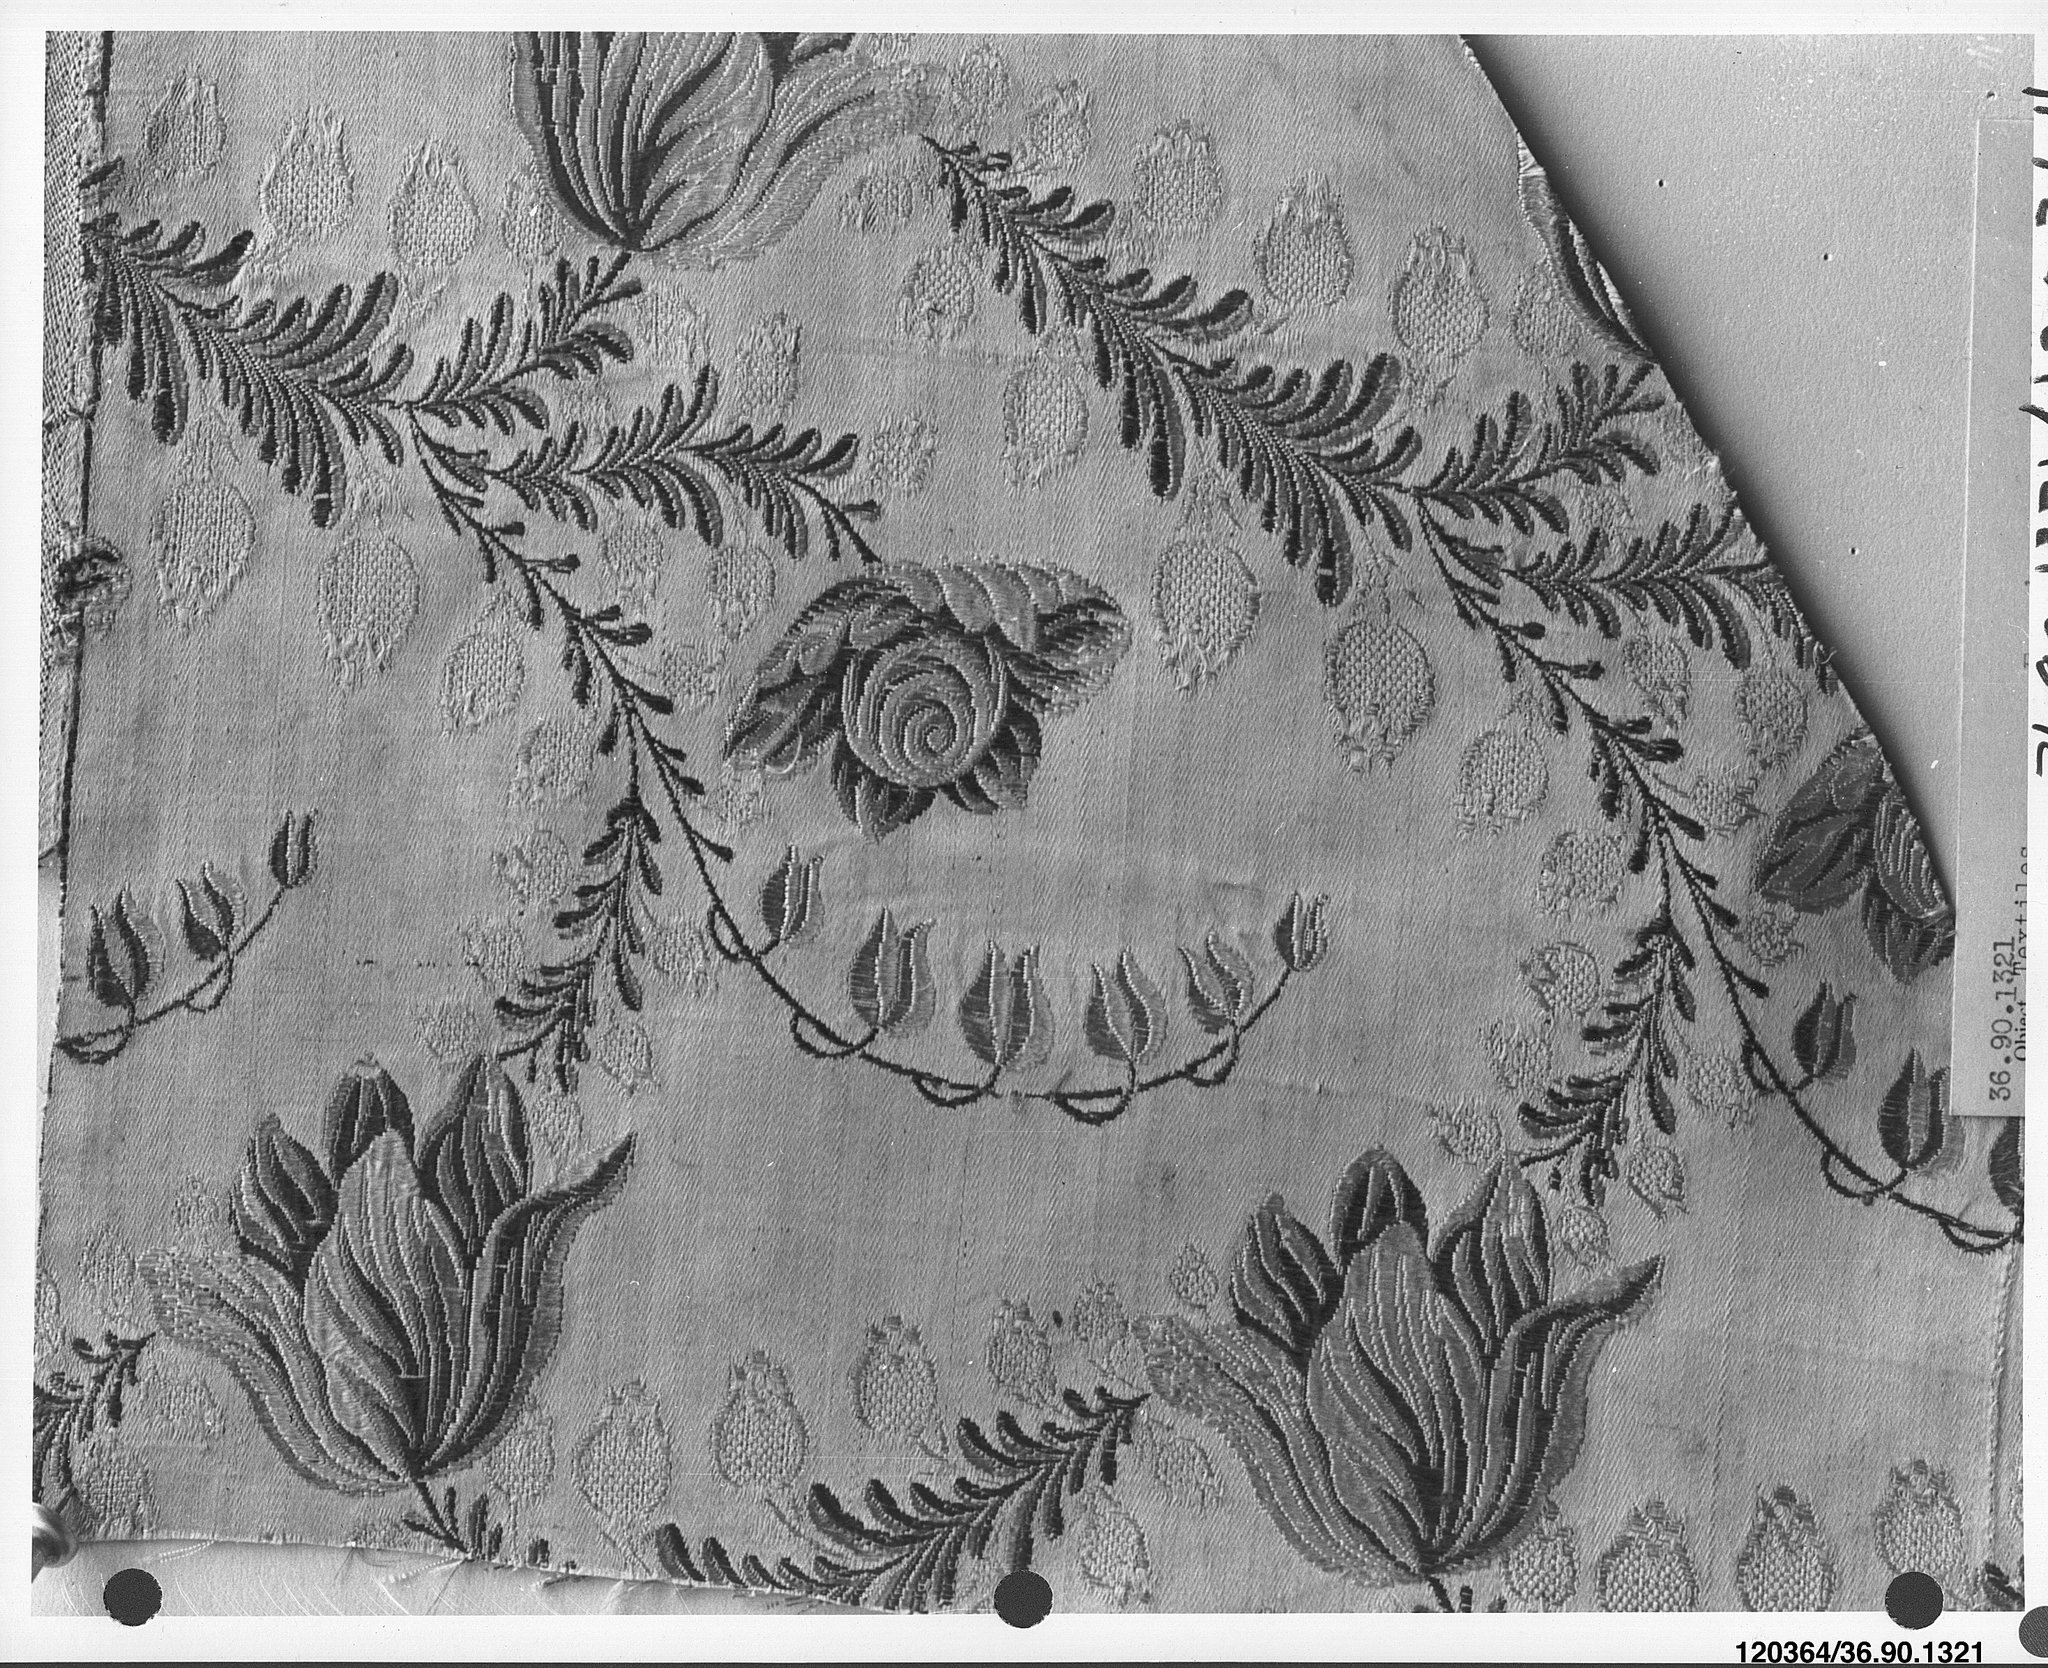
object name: piece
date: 1745-1750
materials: silk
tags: flowers,leaves